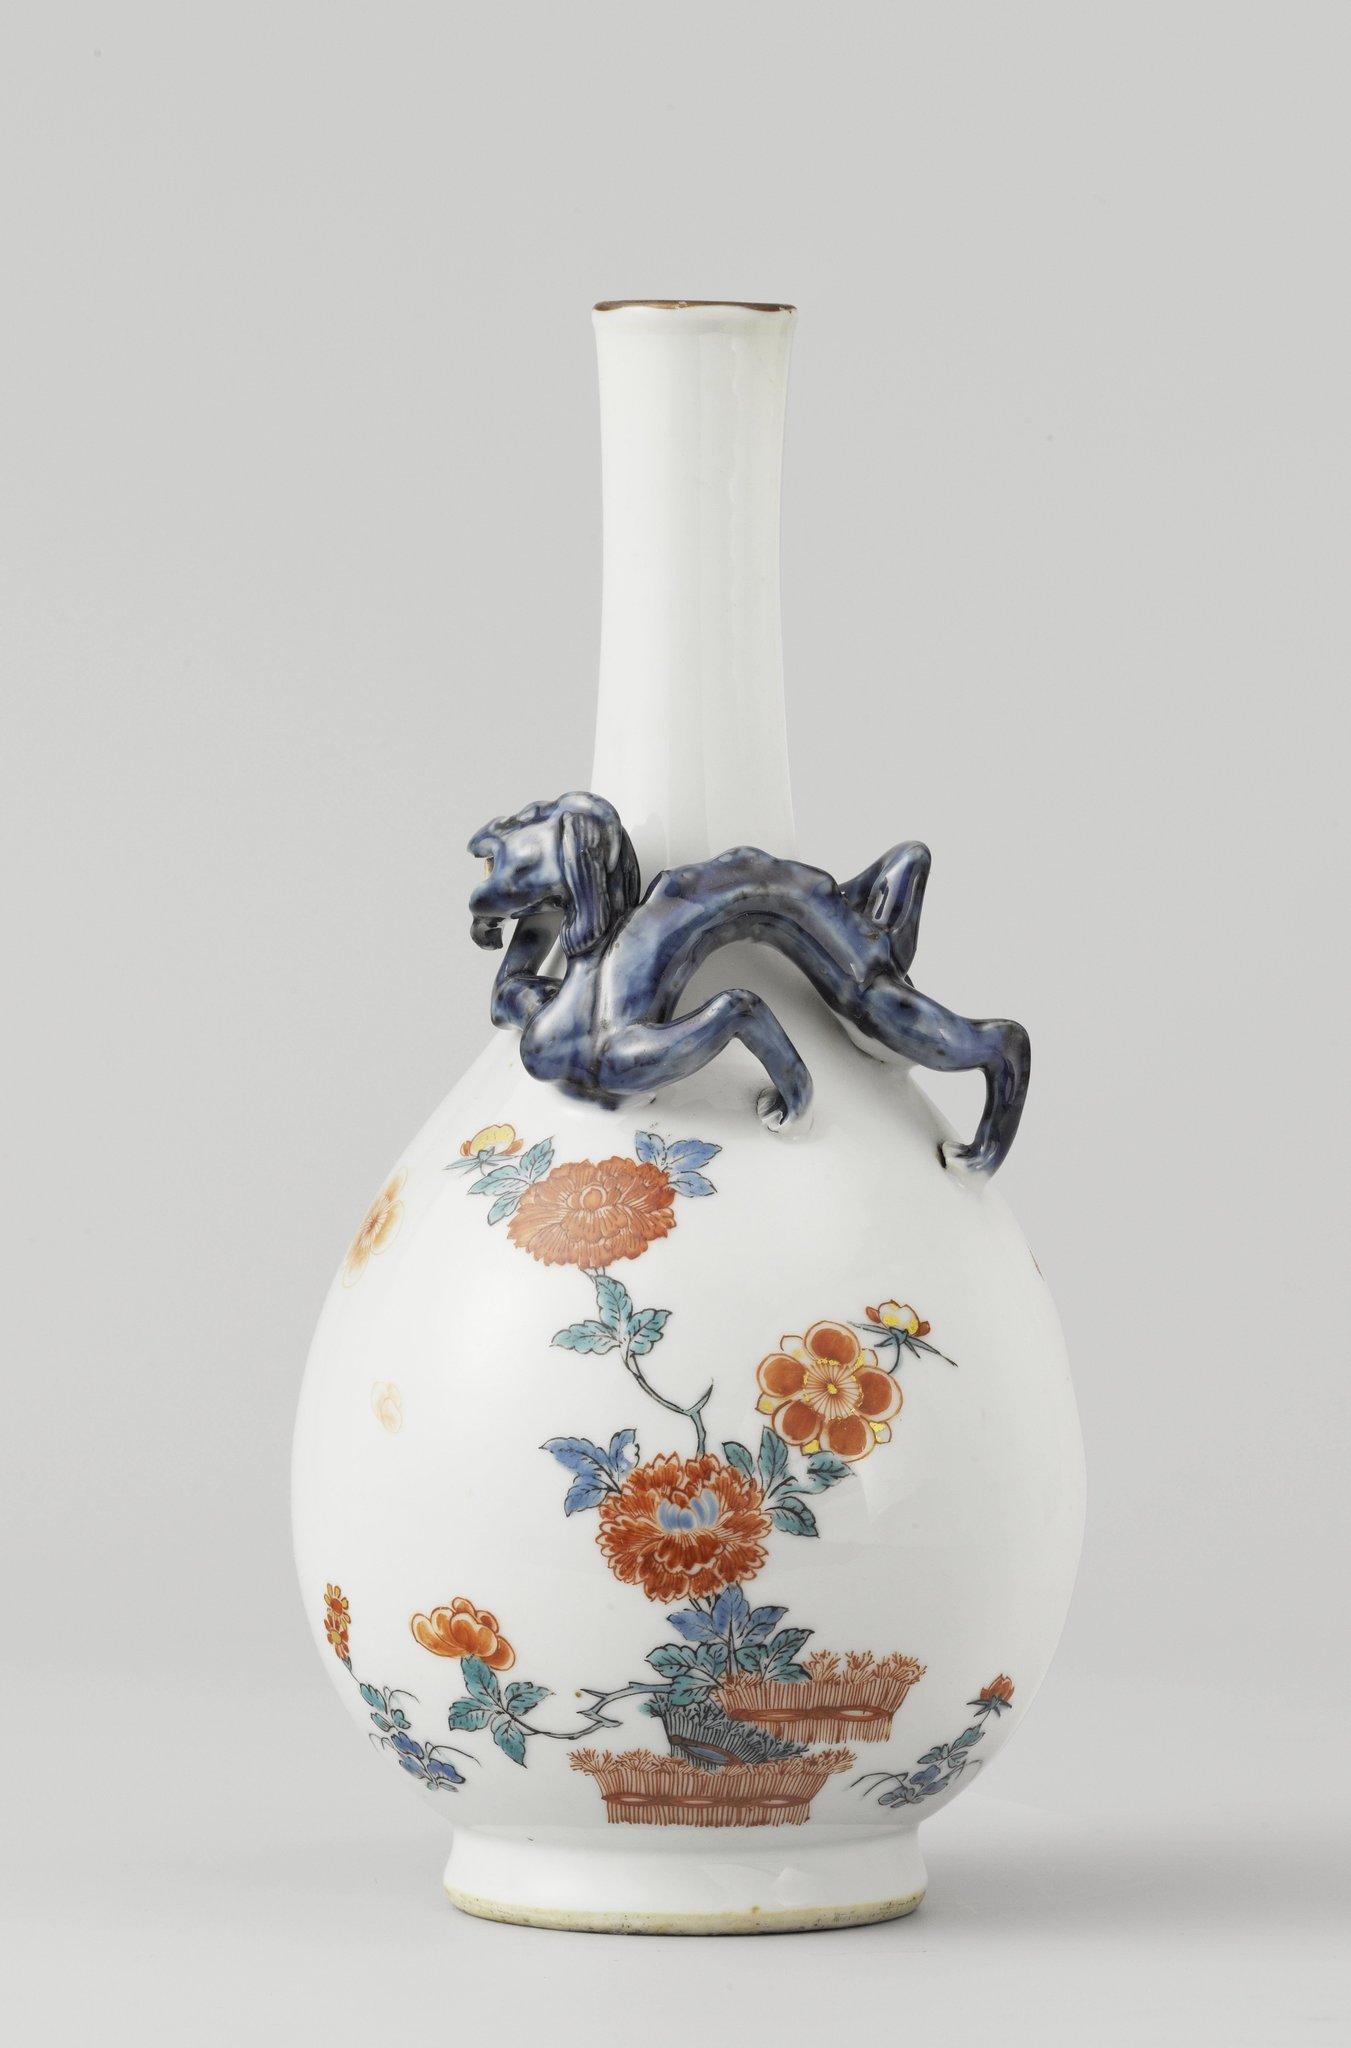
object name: vase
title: Pear-shaped bottle vase with prunus blossoms, hoo-birds and a moulded dragon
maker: Anonymous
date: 1700-1724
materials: glaze, gold, paint, porcelain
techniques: firing, gilding, turning, vitrification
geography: europe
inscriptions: label: ‘Collectie Westendorp/ 96’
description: Vase China, c. 1680 - 1700, decorated, c. 1710 - 1725